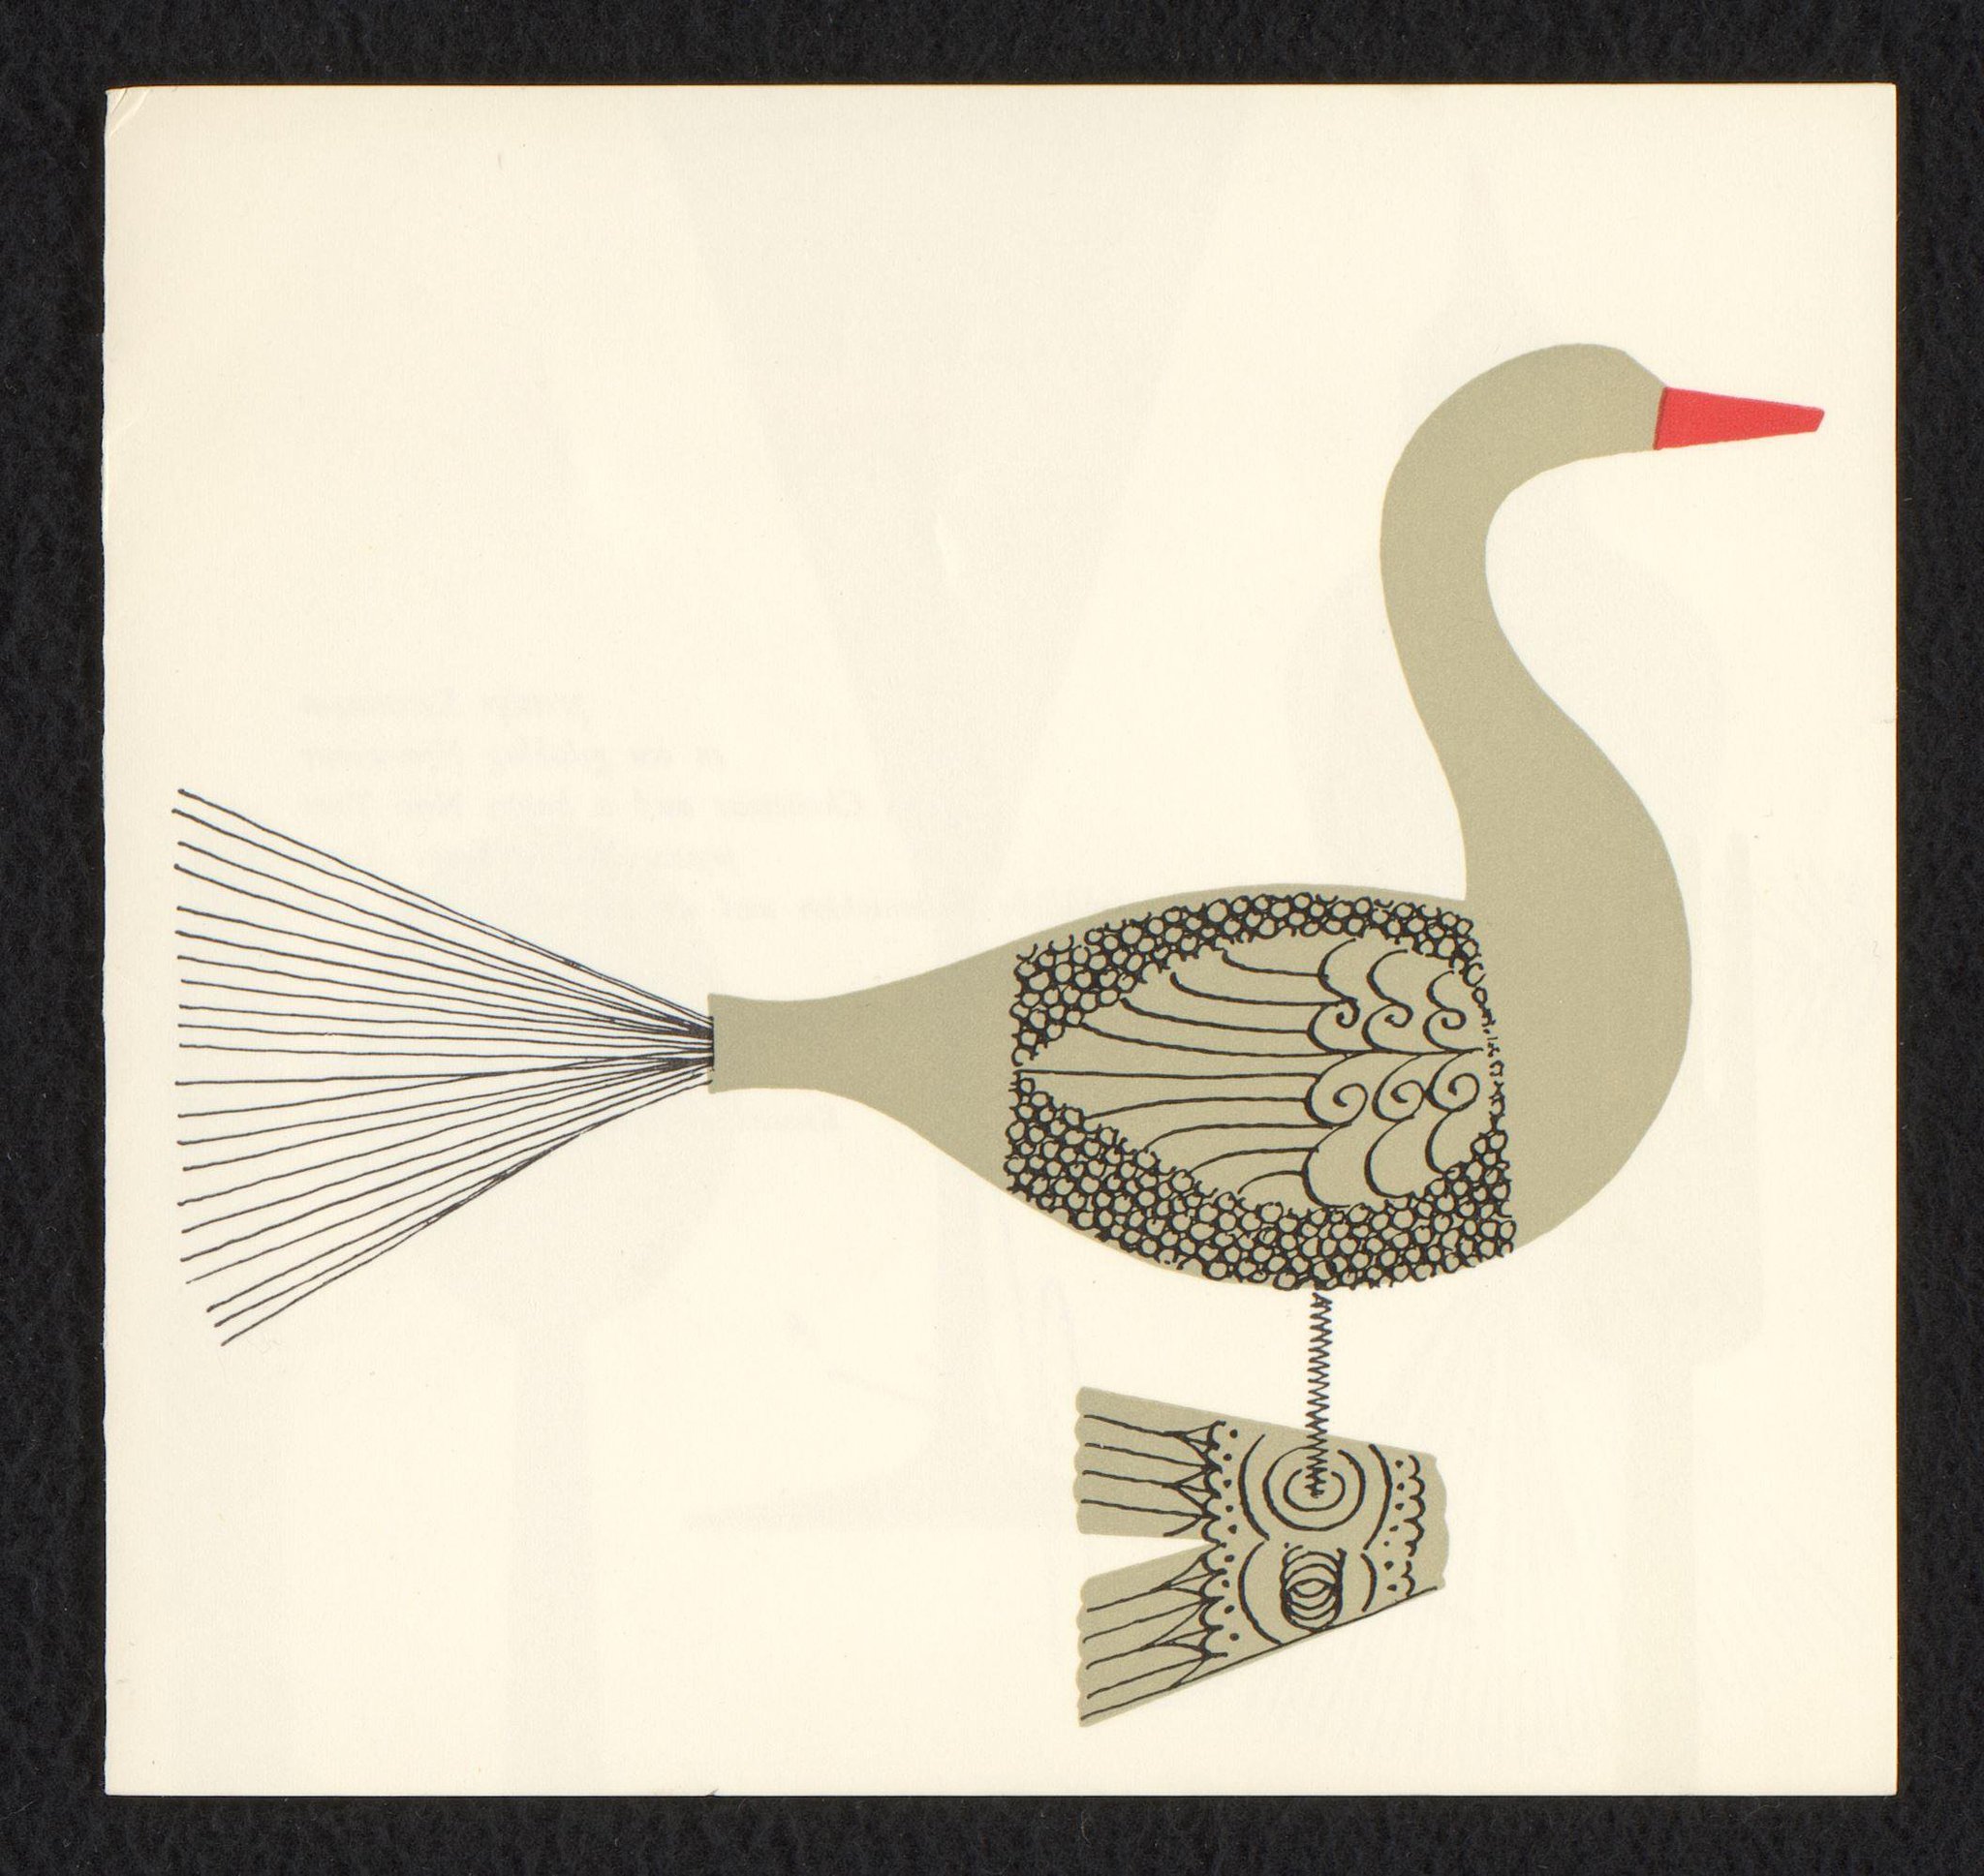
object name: christmas card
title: Kerst- en nieuwjaarswens van Grand Hotel Gooiland, Hotel Hamdorff en Kasteel de Hooge Vuursche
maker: Anonymous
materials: paper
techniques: printing block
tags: table-ware, christmas card, fowl (cock, hen, chicken, etc.)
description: Op de voorzijde een gestileerde vogel. Binnenin rechts een vork en kerst- en nieuwjaarswensen in het Nederlands, Engels, Frans en Duits, evenals een signatuur. Binnenin aan de rechterzijde een mes, een lepel, een glas en een vogel.